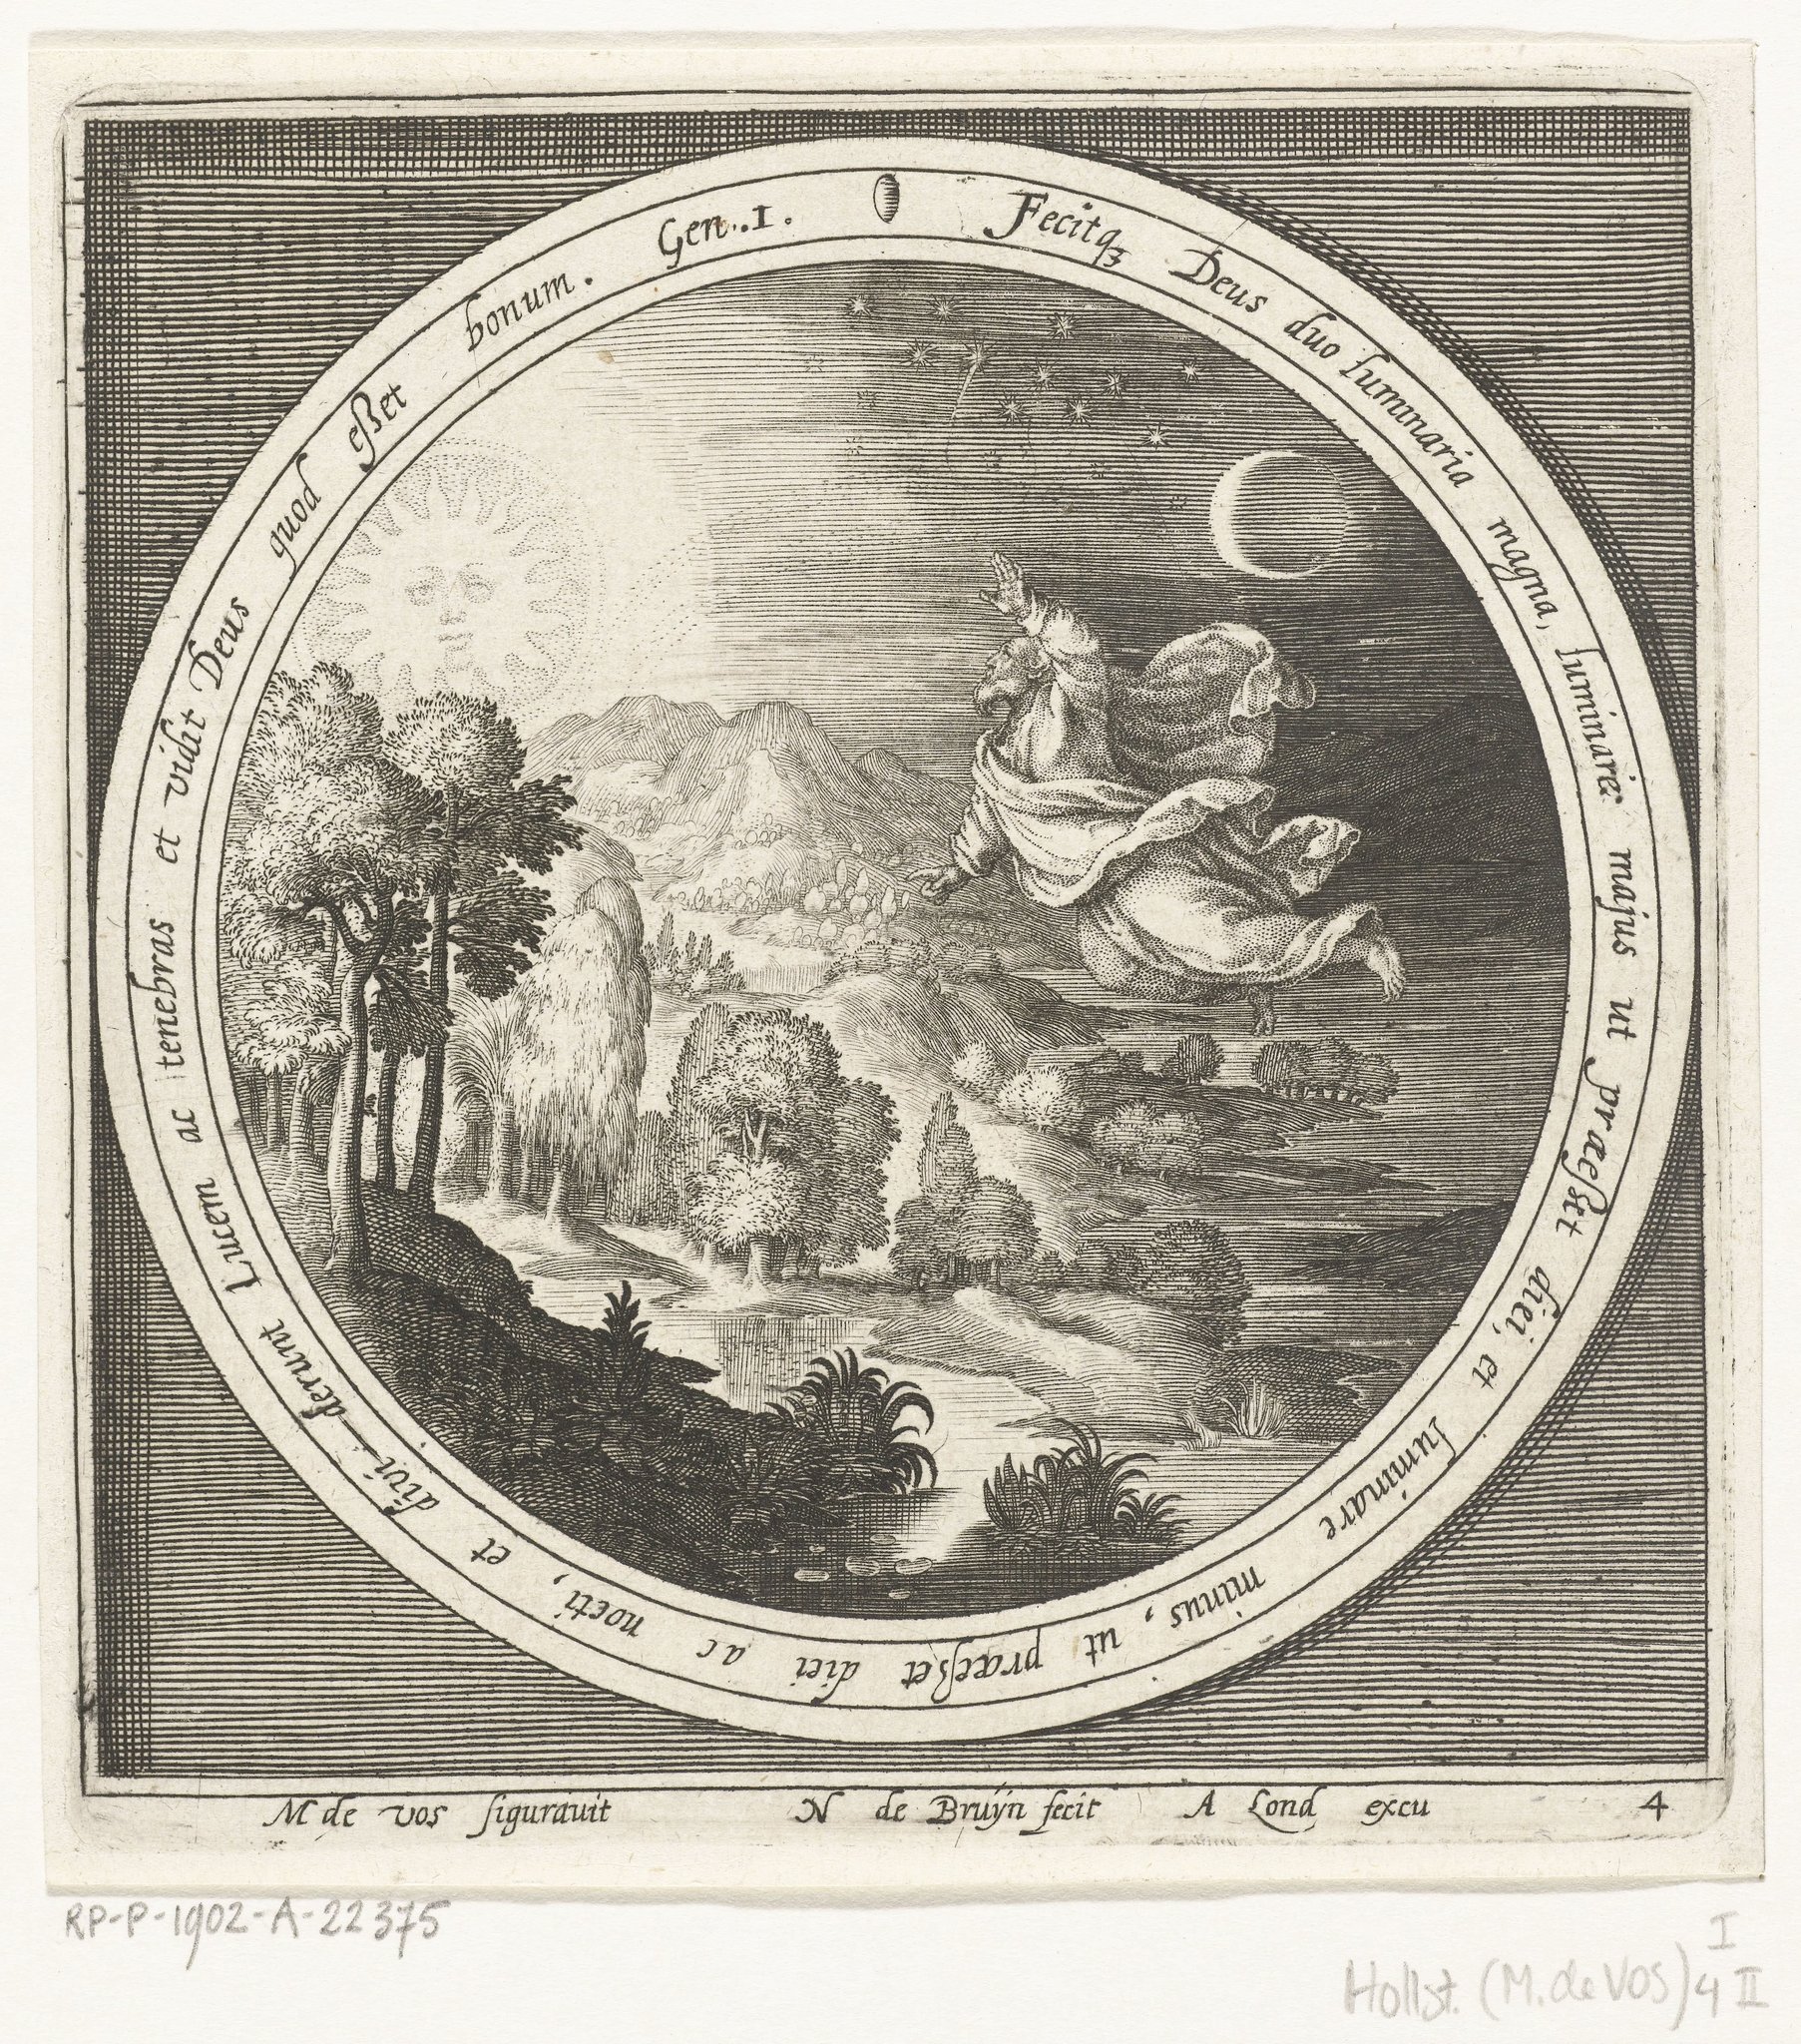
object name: print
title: Van schepping tot verdrijving uit paradijs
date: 1581-1656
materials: paper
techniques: engraving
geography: netherlands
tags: creation of sun, moon and stars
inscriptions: collector's mark: Lugt 2542, collector's mark: Lugt 2228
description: Vierde dag van schepping: God schept de zon, maan en sterren en scheidt zo het licht van de duisternis. In medaillon met als opschrift een bijbeltekst in Latijn uit Genesis 1, binnen rechthoekige omlijsting.